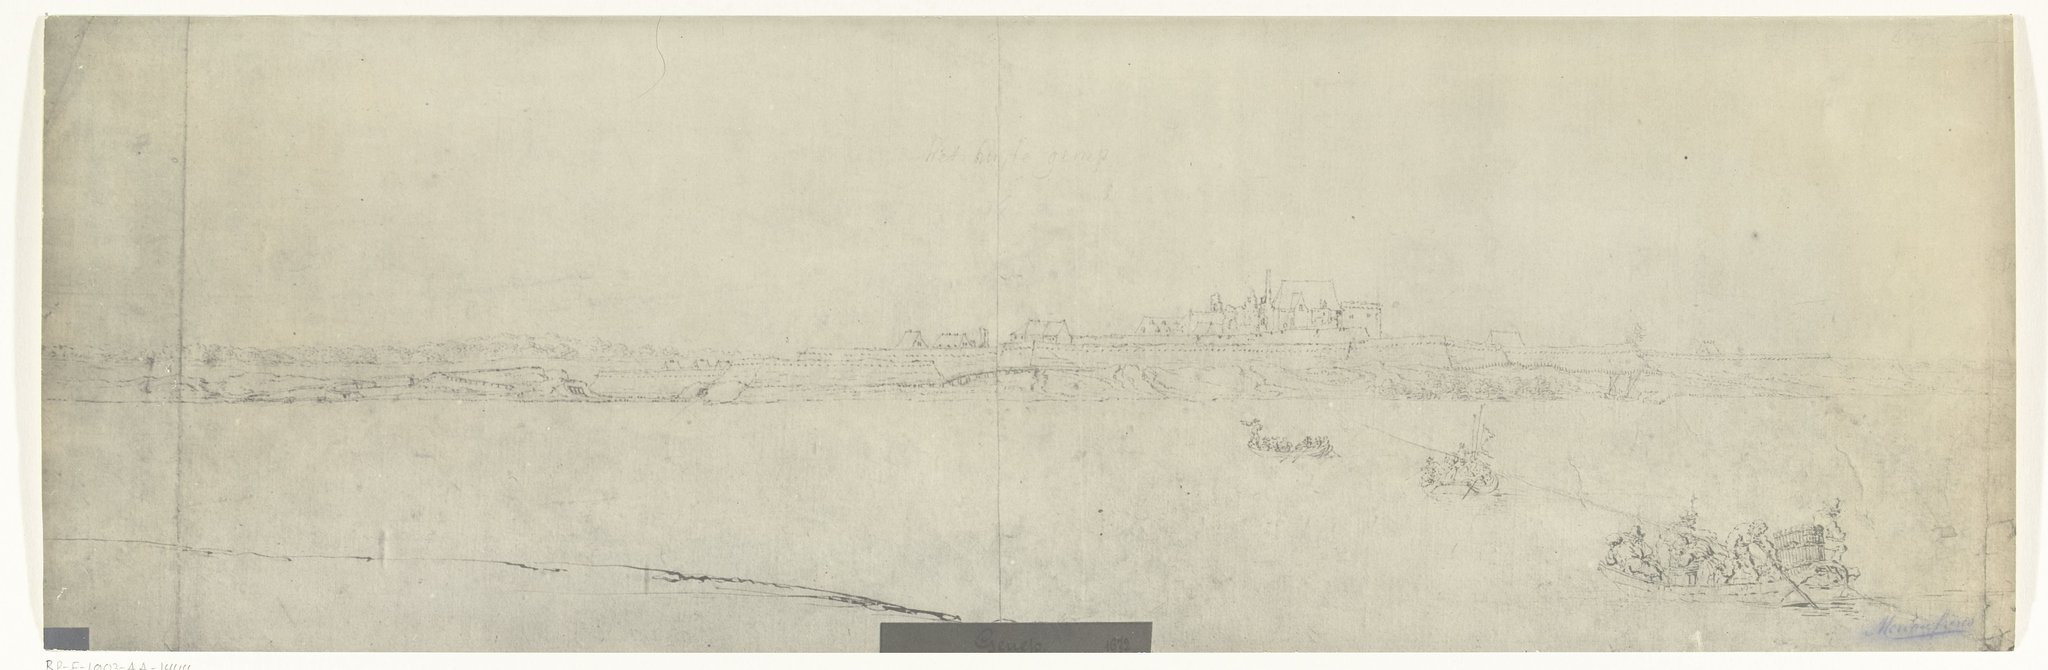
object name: photograph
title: Gezicht op het Huis te Gennep, 1672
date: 1900-1903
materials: paper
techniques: gelatin silver print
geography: france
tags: lodewijk xiv (koning van frankrijk), permanent fortifications, prospect of city, town panorama, silhouette of city, rampjaar (disaster year)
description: Niet in Frederik Muller; door het RPK toegevoegd nummer. Onderdeel van een groep van ca. 50 foto's van tekeningen van de Franse inval in de Nederlanden in 1672 door Adam Frans van der Meulen, bewaard in de Manufacture Nationale des Gobelins te Parijs.